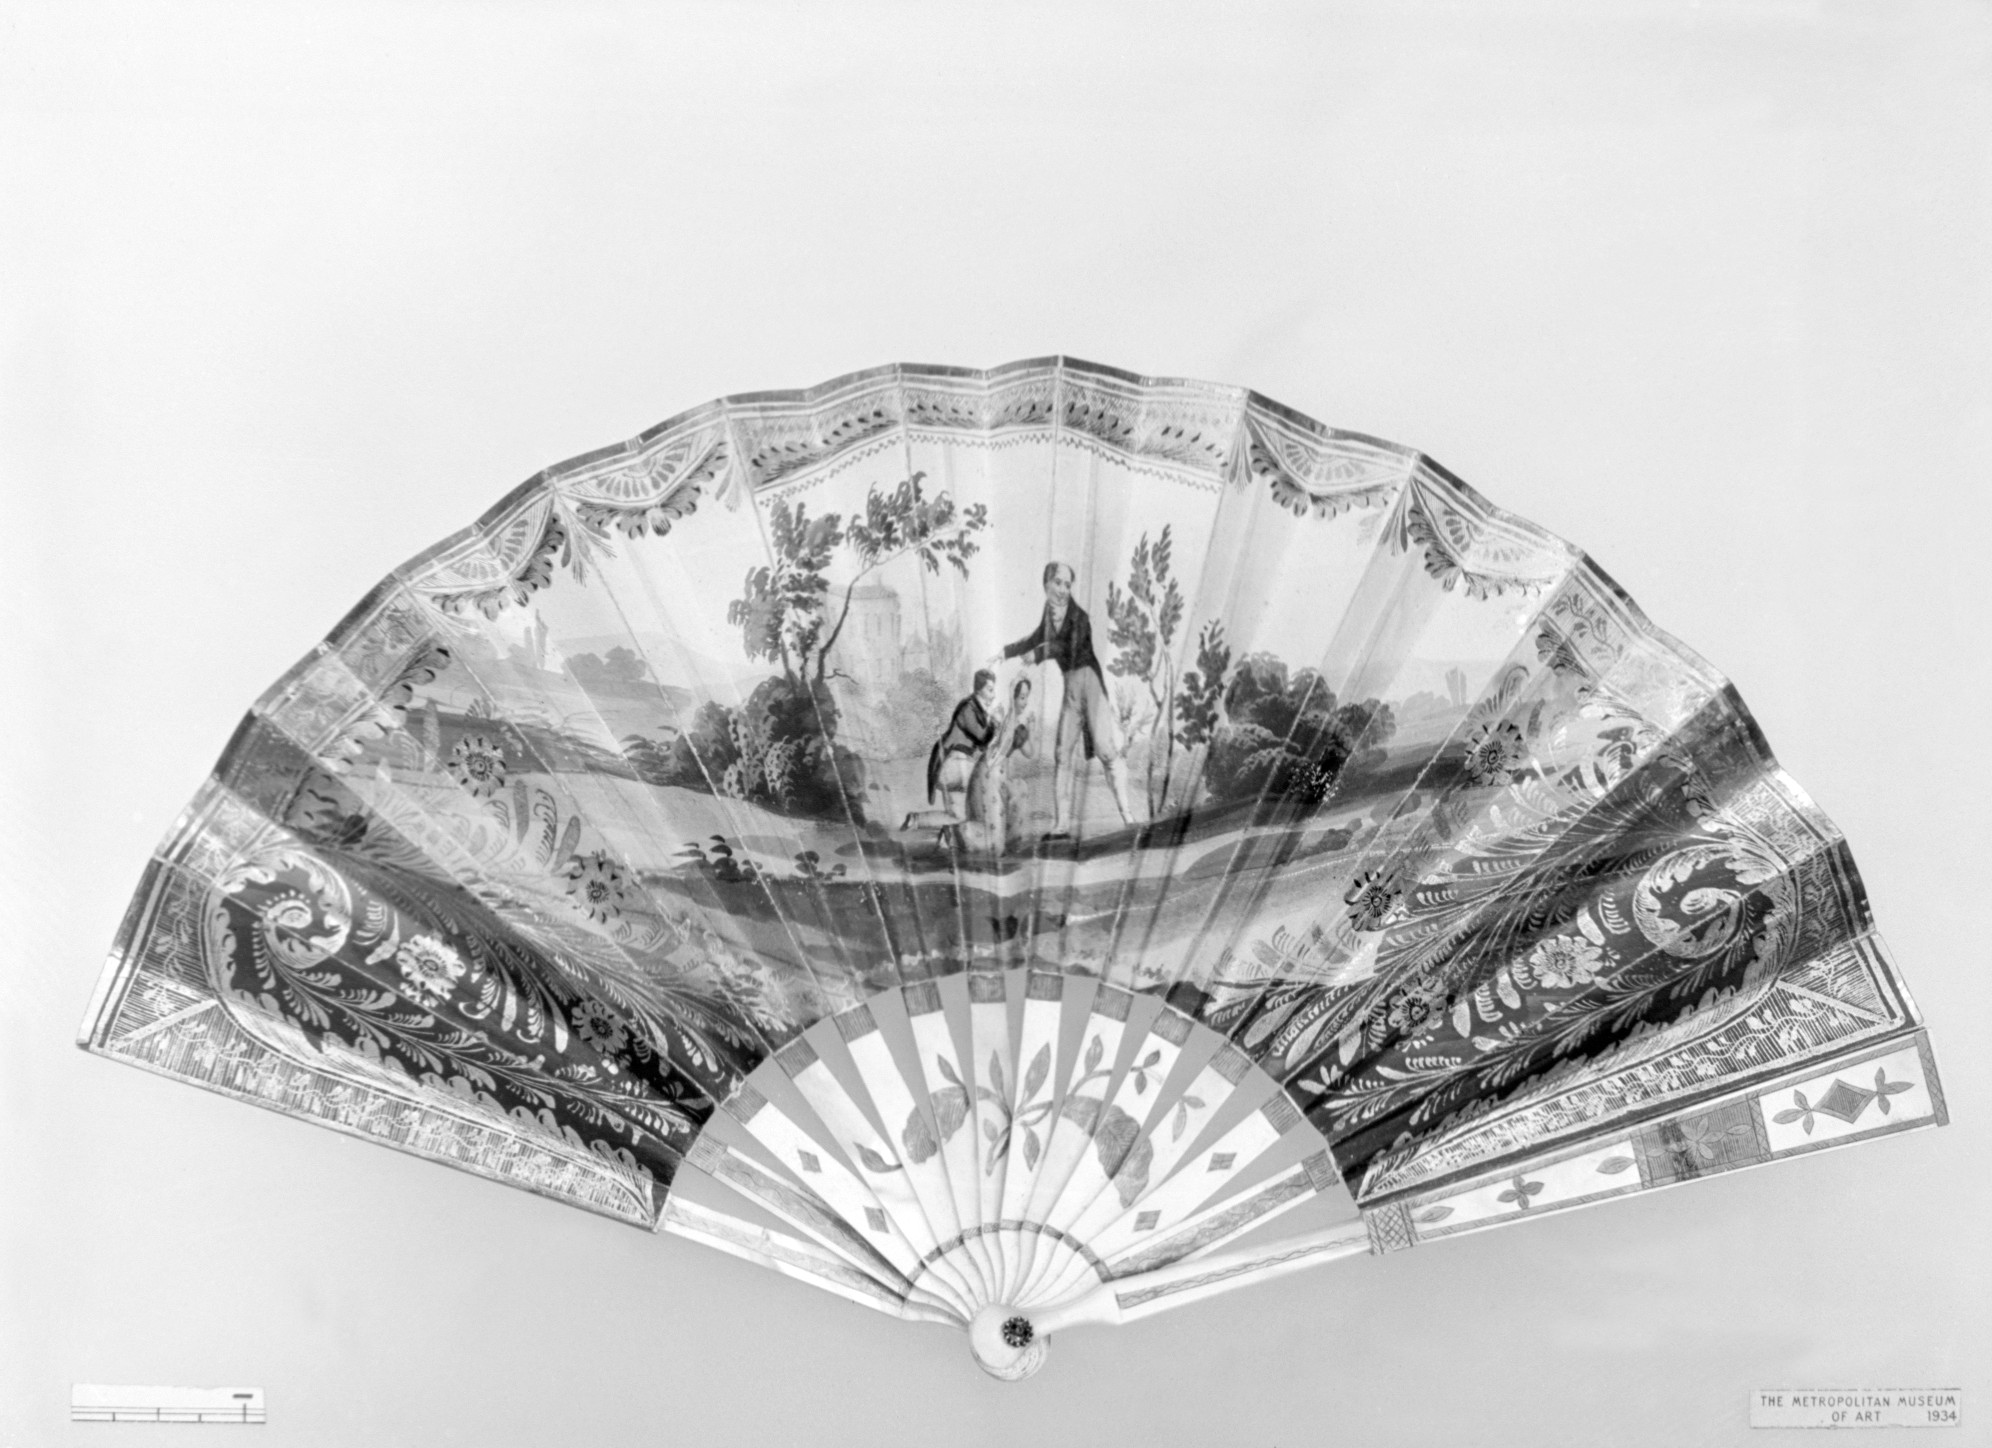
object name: fan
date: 1820-1835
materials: gilt, mother of pearl, paper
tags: men,women